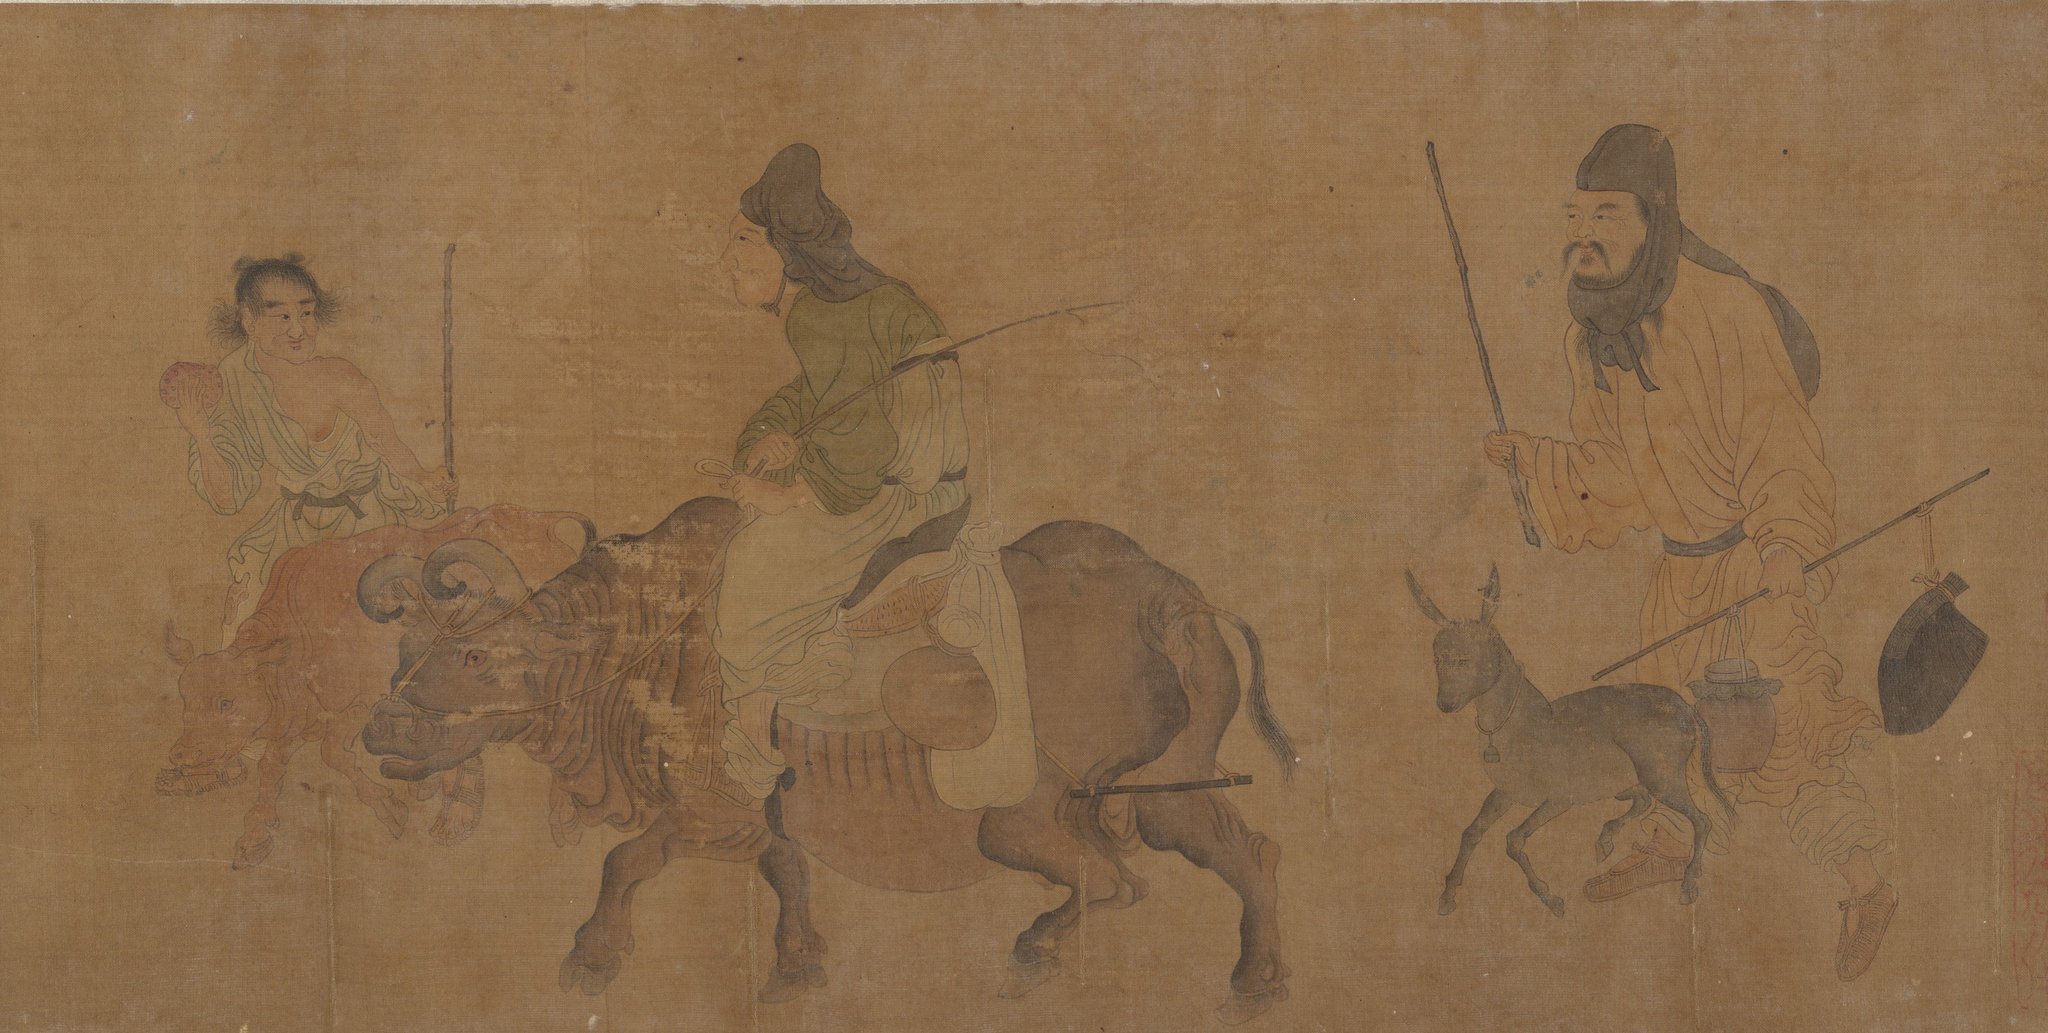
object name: handscroll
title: Happy Return from the West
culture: chinese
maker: unidentified artist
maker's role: artist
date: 1368-1644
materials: ink, silk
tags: men,bulls